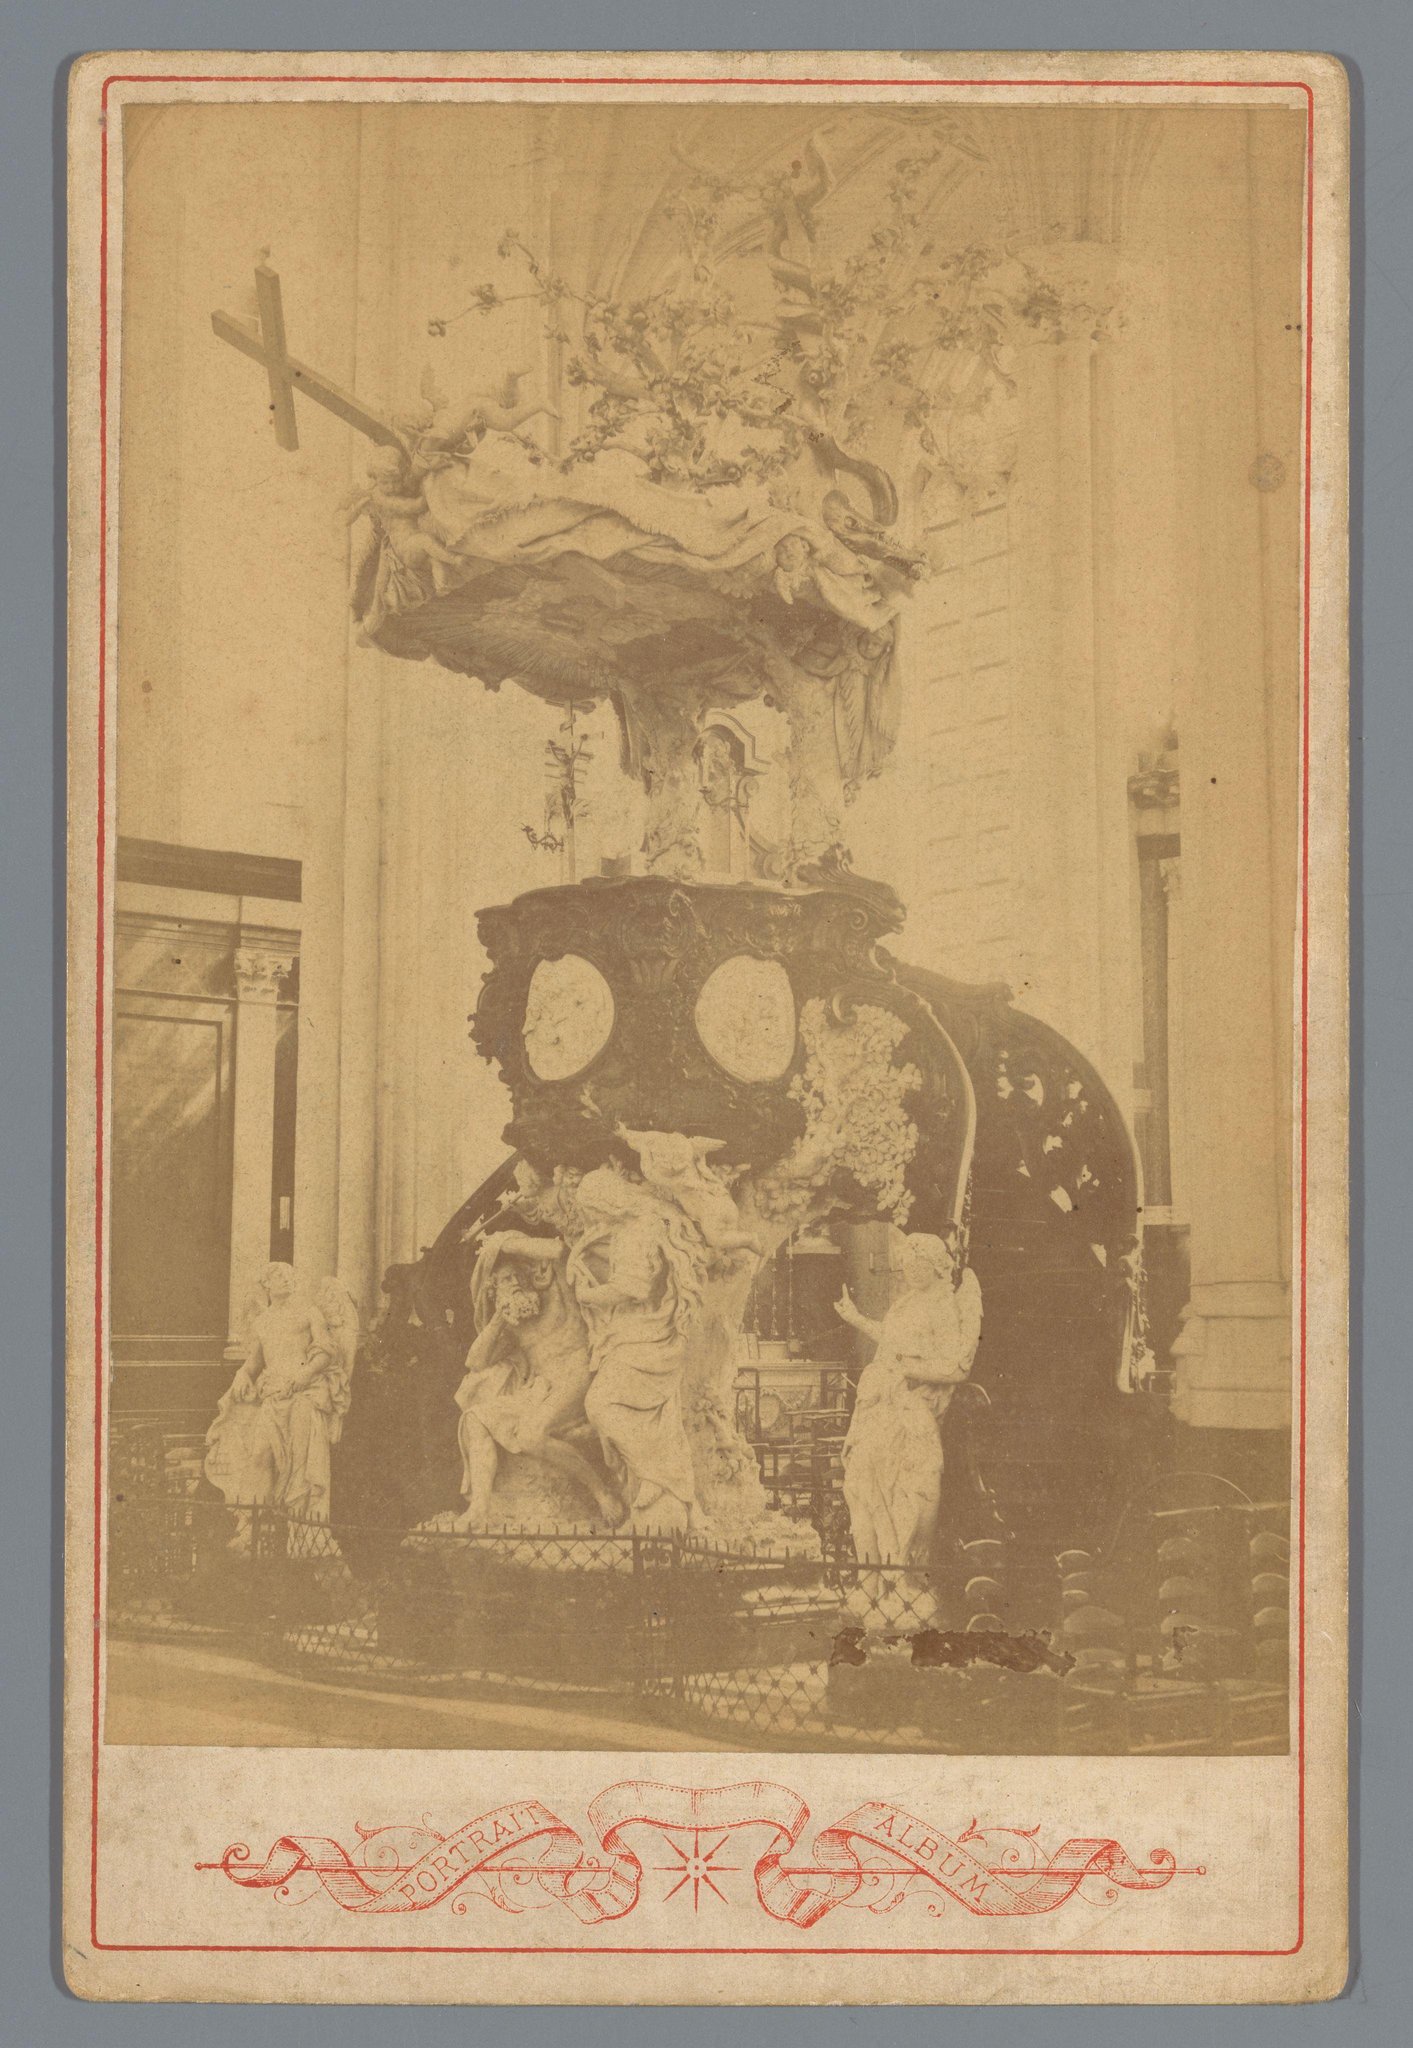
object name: cabinet photograph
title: Spreekstoel in de Sint Baafskathedraal in Gent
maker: frédéric deloeul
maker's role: fotograaf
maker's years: 1851-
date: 1850-1900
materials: cardboard, photographic support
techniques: albumen print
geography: sint-baafskathedraal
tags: pulpit, ambo, chancel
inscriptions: inscription: ‘Portrait Album’, annotation: ‘Chaire de Verite a l'Eglise St. Nicolas/ Gand’, inscription: ‘Les clichets se conservent indéfiniment.’, address: ‘Photographie/ A. F. Deoeul/ Rue Neuve, 3/ Bruxelles’, annotation: ‘18 Aug. [...]’